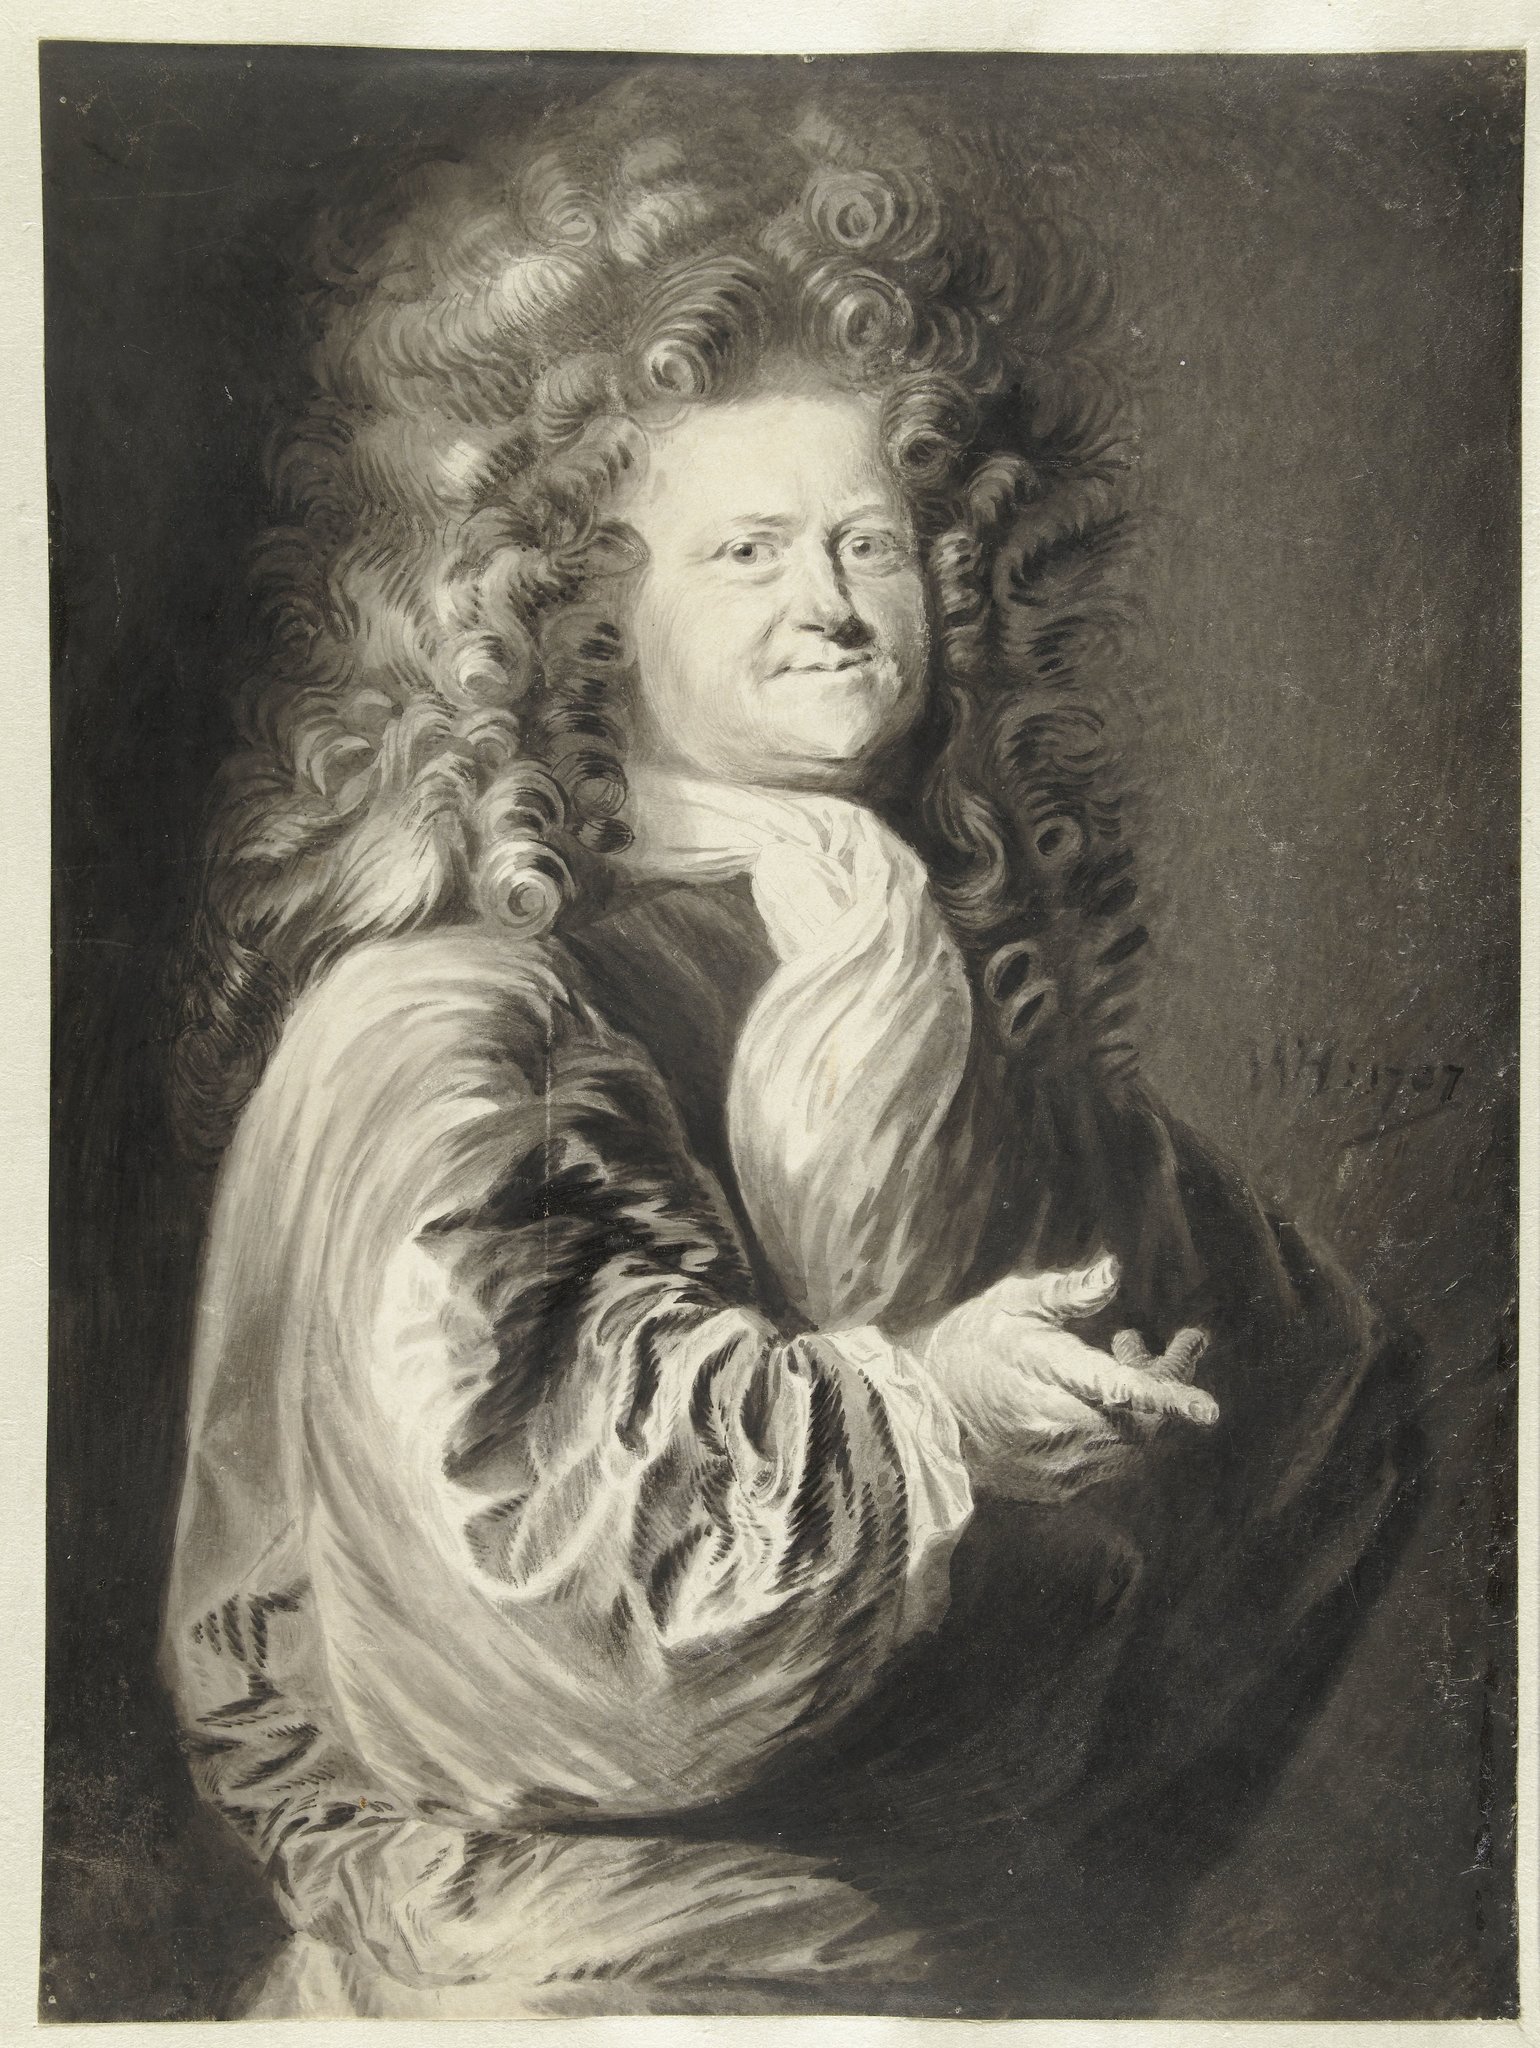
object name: drawing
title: Mansportret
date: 1707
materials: parchment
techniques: brush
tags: anonymous historical person portrayed alone